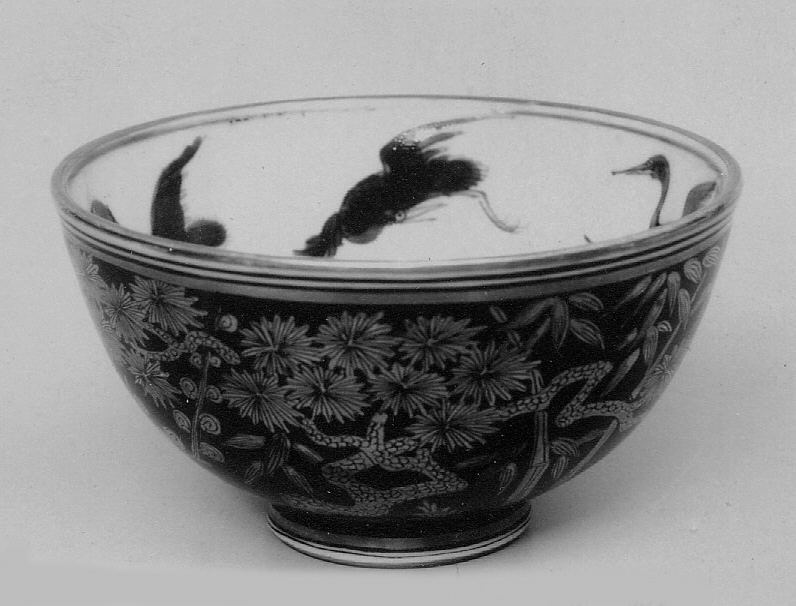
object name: bowl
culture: japanese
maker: eiraku hozen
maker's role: artist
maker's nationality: japanese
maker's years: 1795-1854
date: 1800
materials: glaze, porcelain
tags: birds